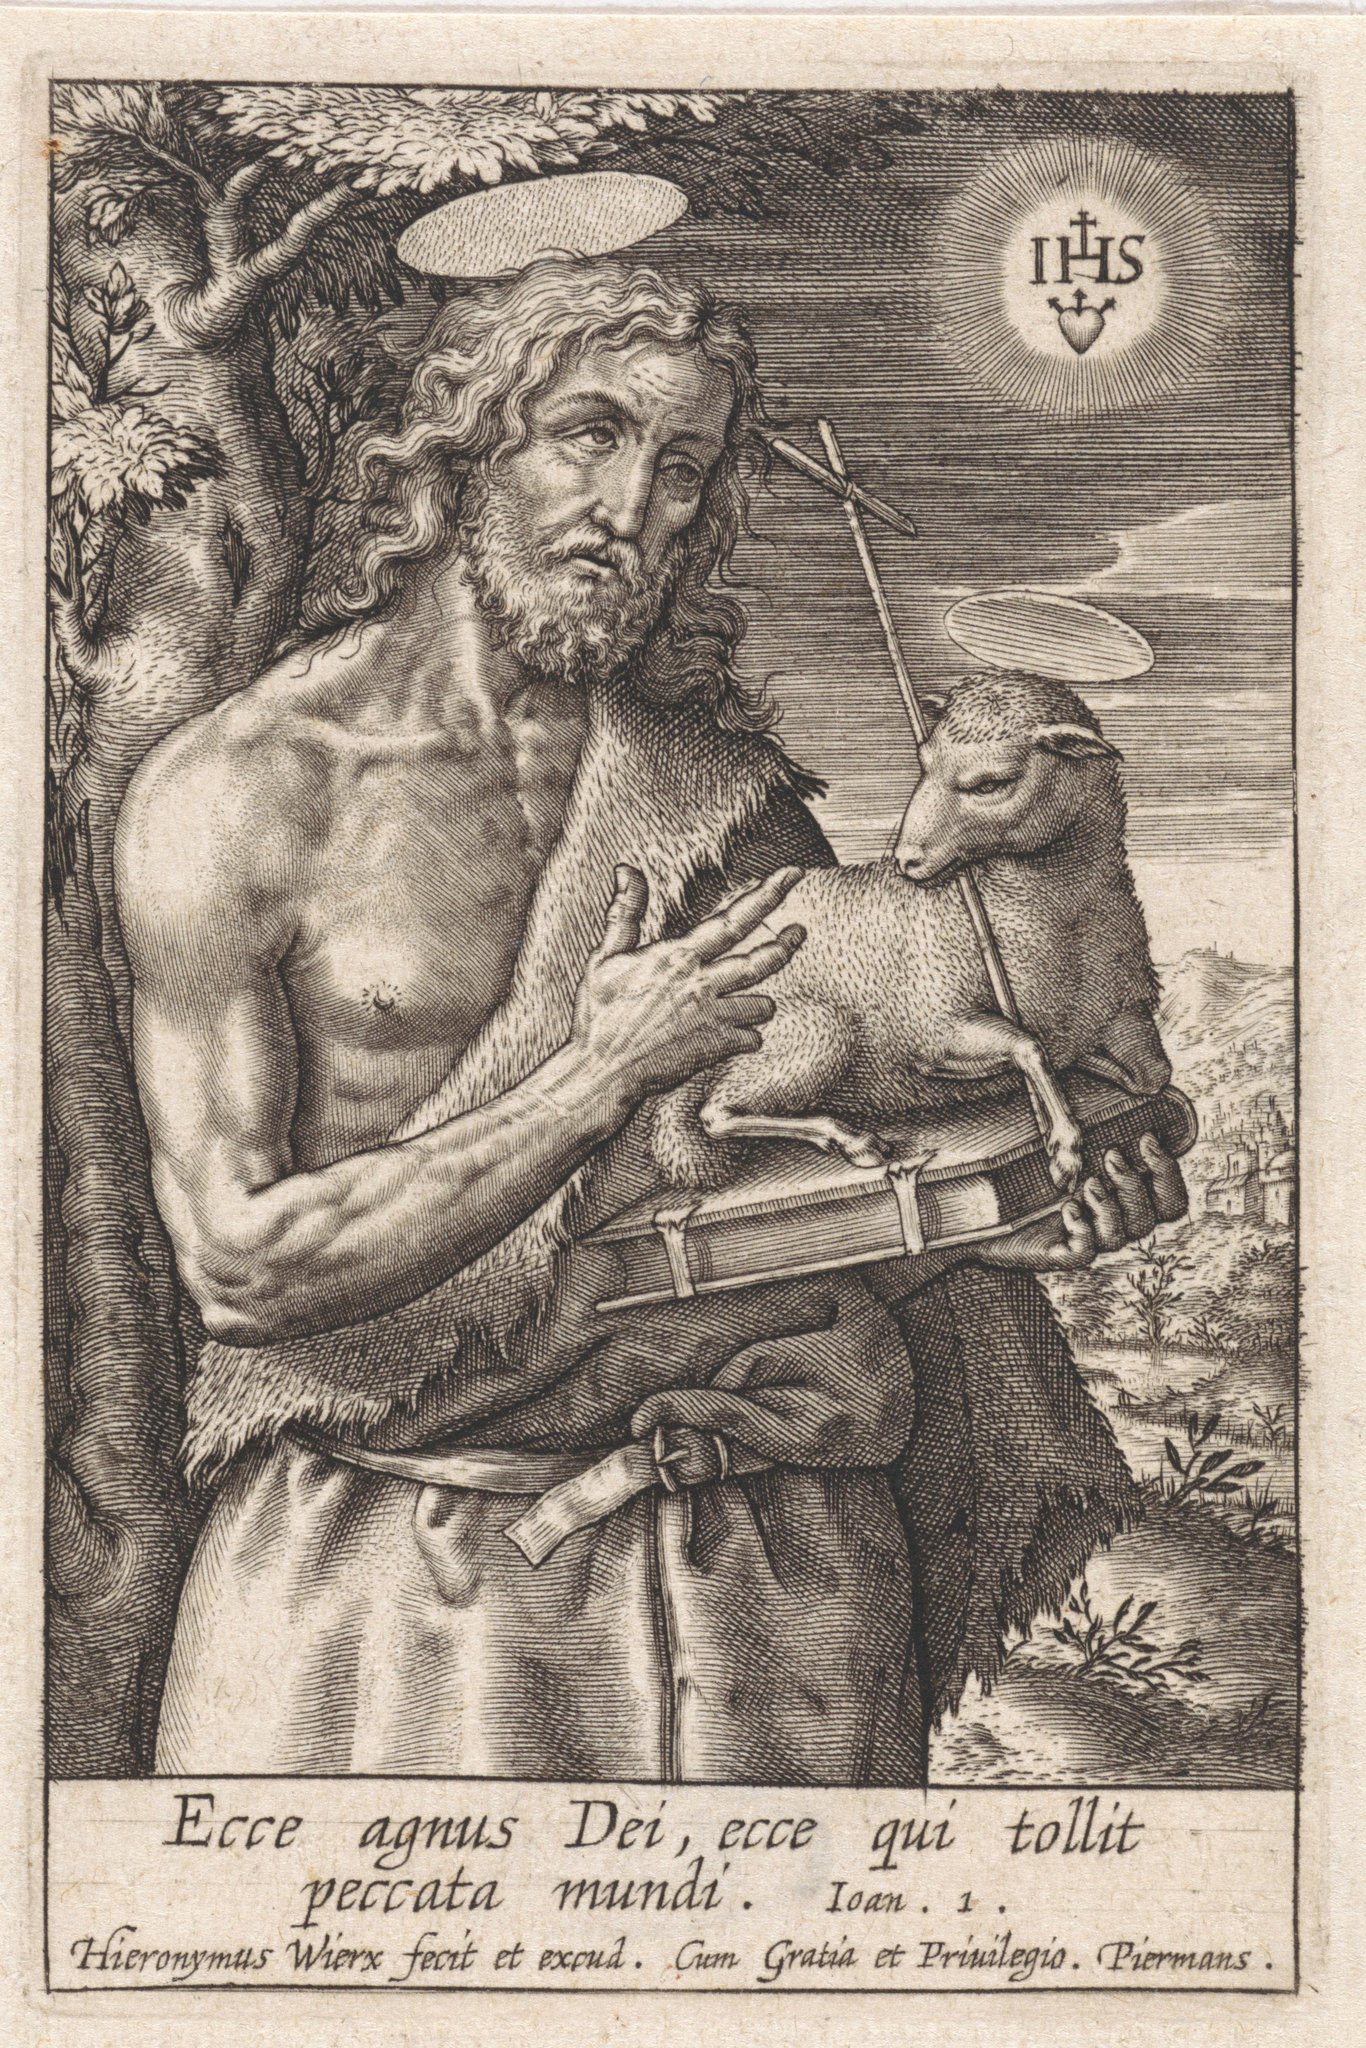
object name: print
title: Johannes de Doper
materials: paper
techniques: engraving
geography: antwerp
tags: john the baptist; possible attributes: book, reed cross, baptismal cup, honeycomb, lamb, staff, ihs ('iesus hominum salvator') ~ symbol of christ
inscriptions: collector's mark: Lugt 2228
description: Landschap met Johannes de Doper, gekleed in een kamelenhuid, in zijn hand houdt hij een Bijbel waar het Lam op ligt. In de lucht het symbool van de jezuïeten. In de marge een tweeregelig Bijbelcitaat uit Joh. 1 in het Latijn.